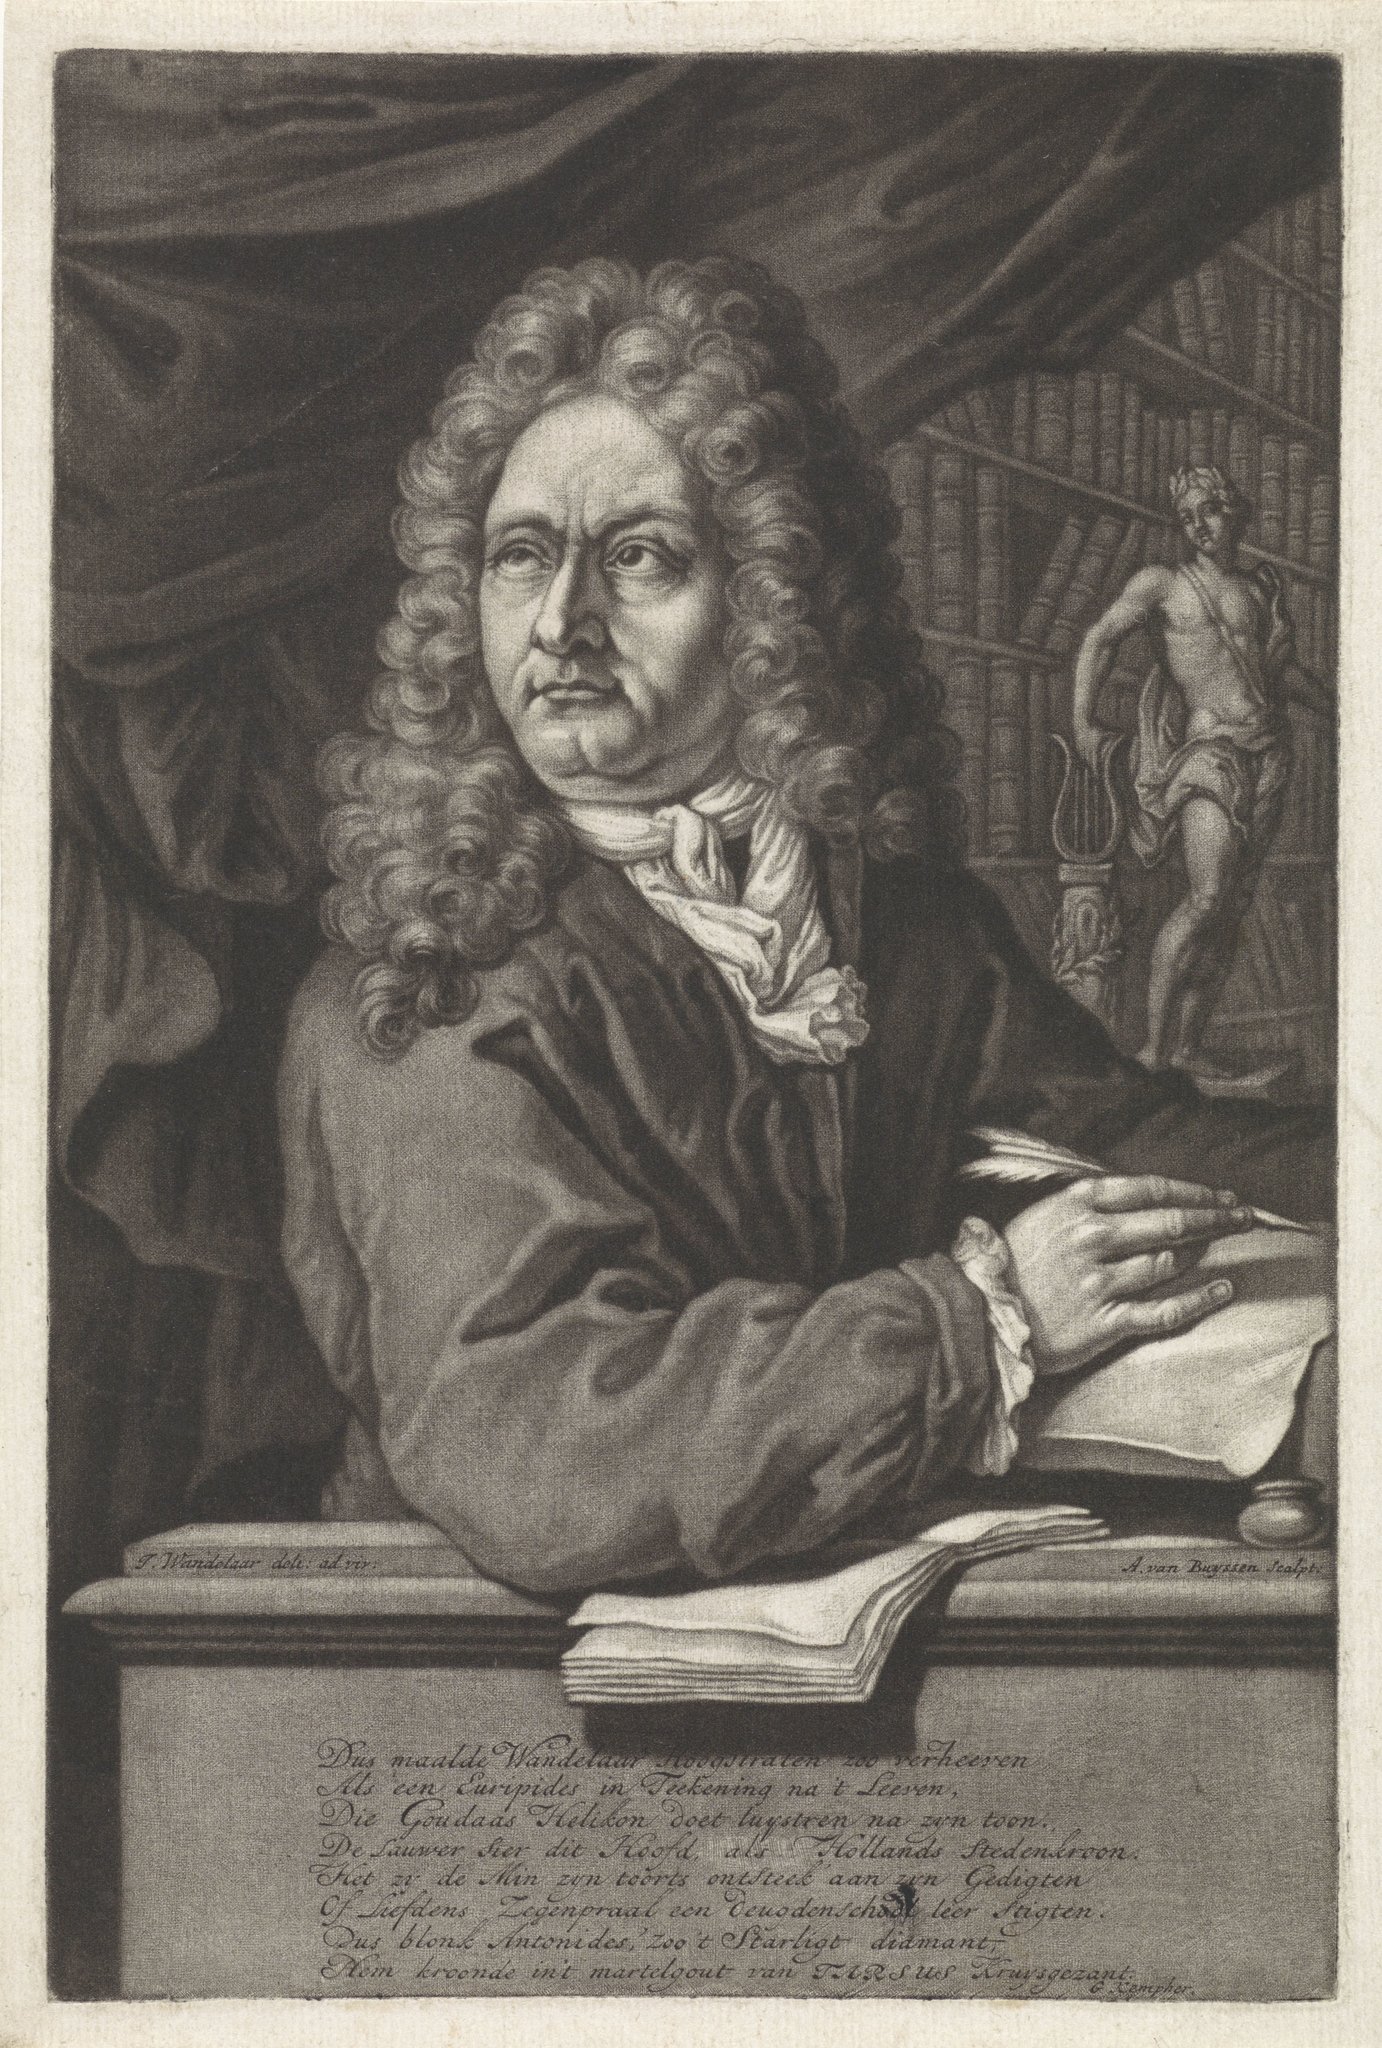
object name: print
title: Portret van Jan van Hoogstraten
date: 1700-1747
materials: paper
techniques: engraving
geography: amsterdam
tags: bookseller, quill, writing tools, wig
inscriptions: collector's mark: Lugt 2228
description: Portret van de schrijver en boekverkoper Jan van Hoogstraten. Hij houdt in de hand een vel papier en een schrijfveer. Op de achtergrond een boekenkast en een sculptuur.